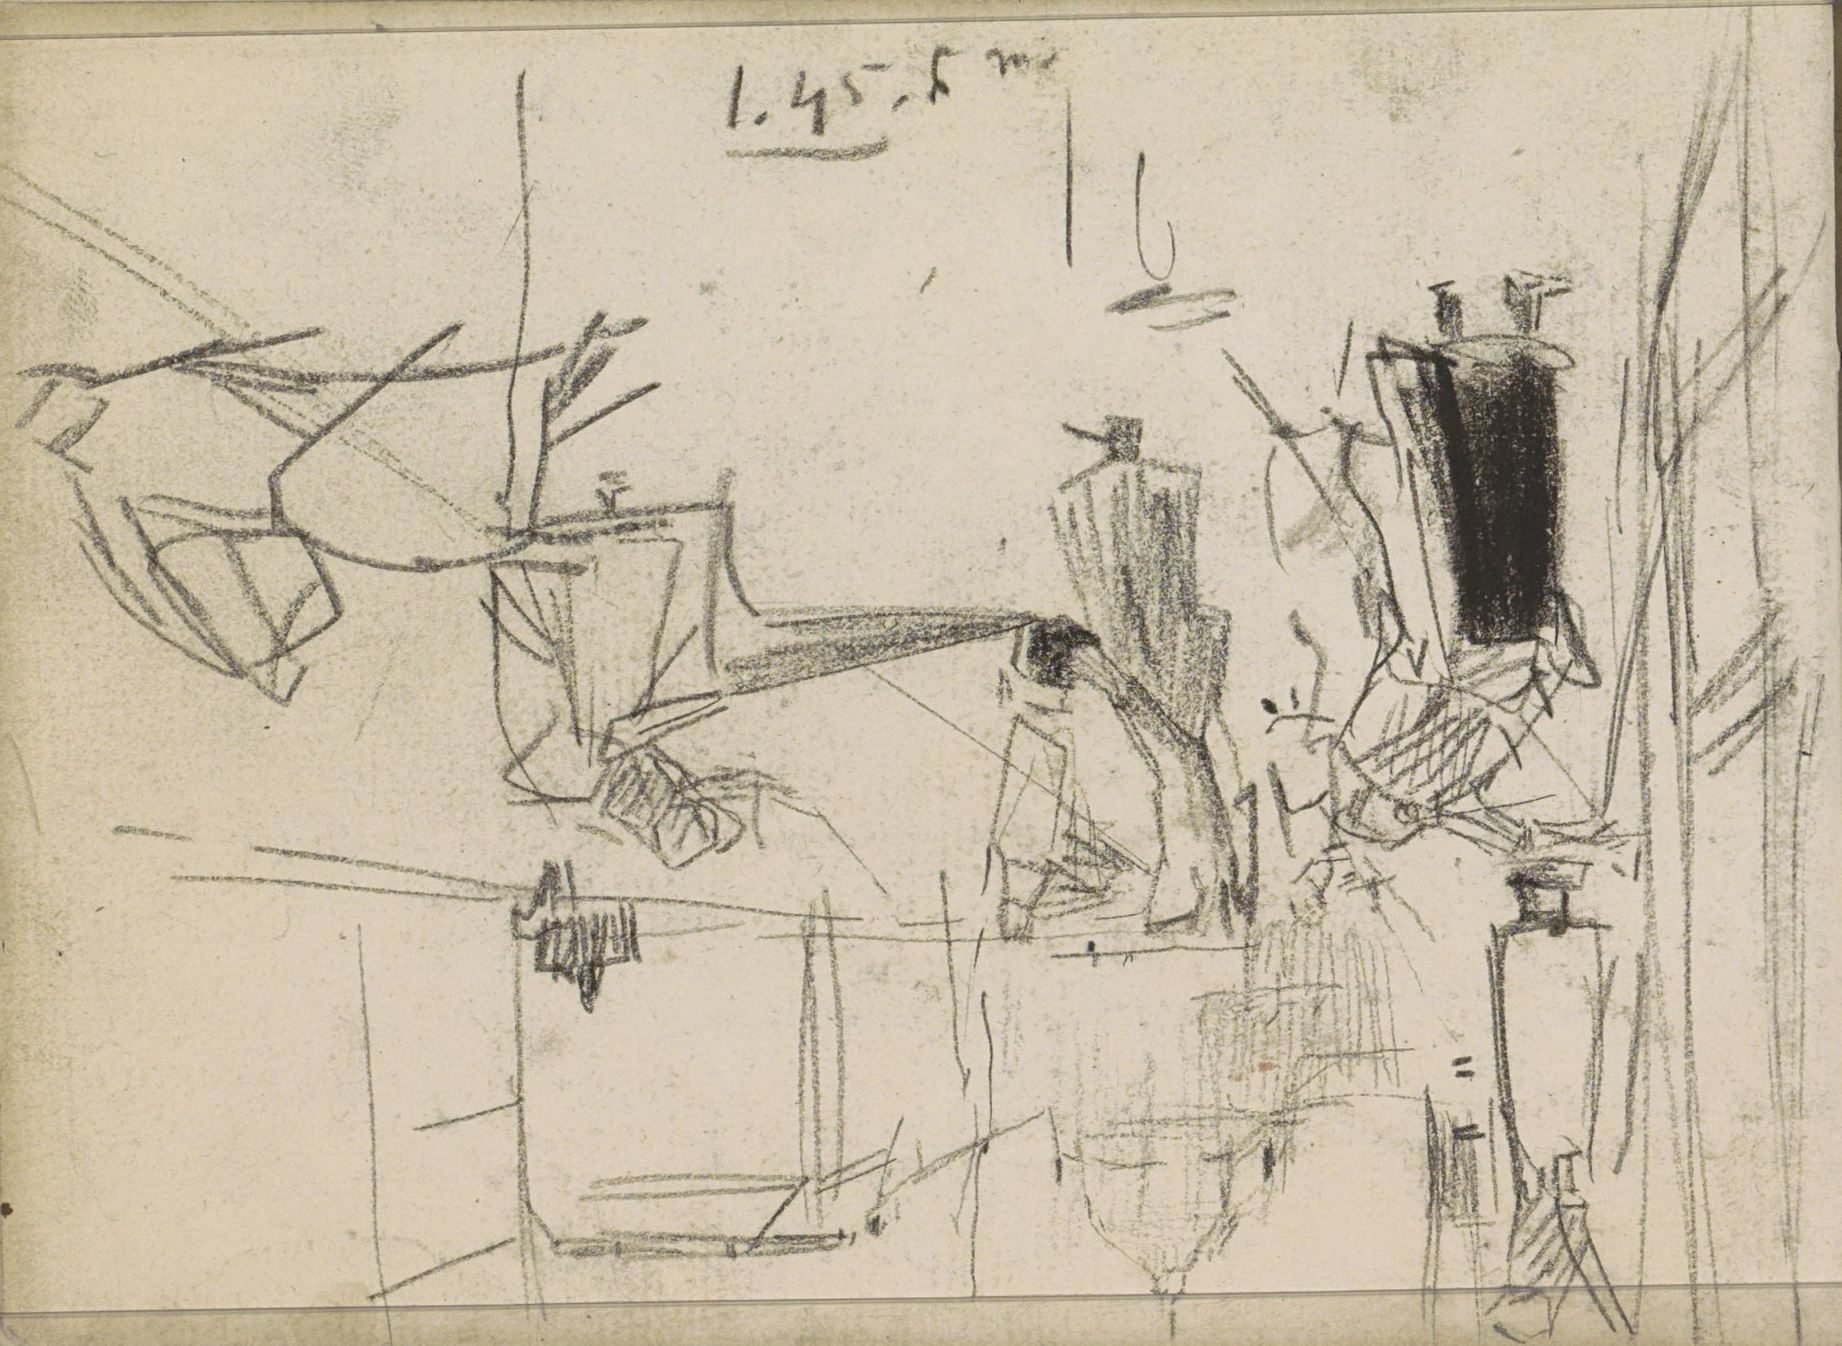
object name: sketchbook leaf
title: Dienstmeiden op straat, mogelijk in Amsterdam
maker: isaac israels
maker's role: draughtsman, painter, print maker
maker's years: 1865-1934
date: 1886-1903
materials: chalk, paper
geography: amsterdam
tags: maid ~ house personnel, street (+ city(-scape) with figures, staffage), amsterdam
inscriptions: annotation: ‘1.45 [...]’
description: Pagina 50 uit schetsboek XLVII met 52 pagina's.